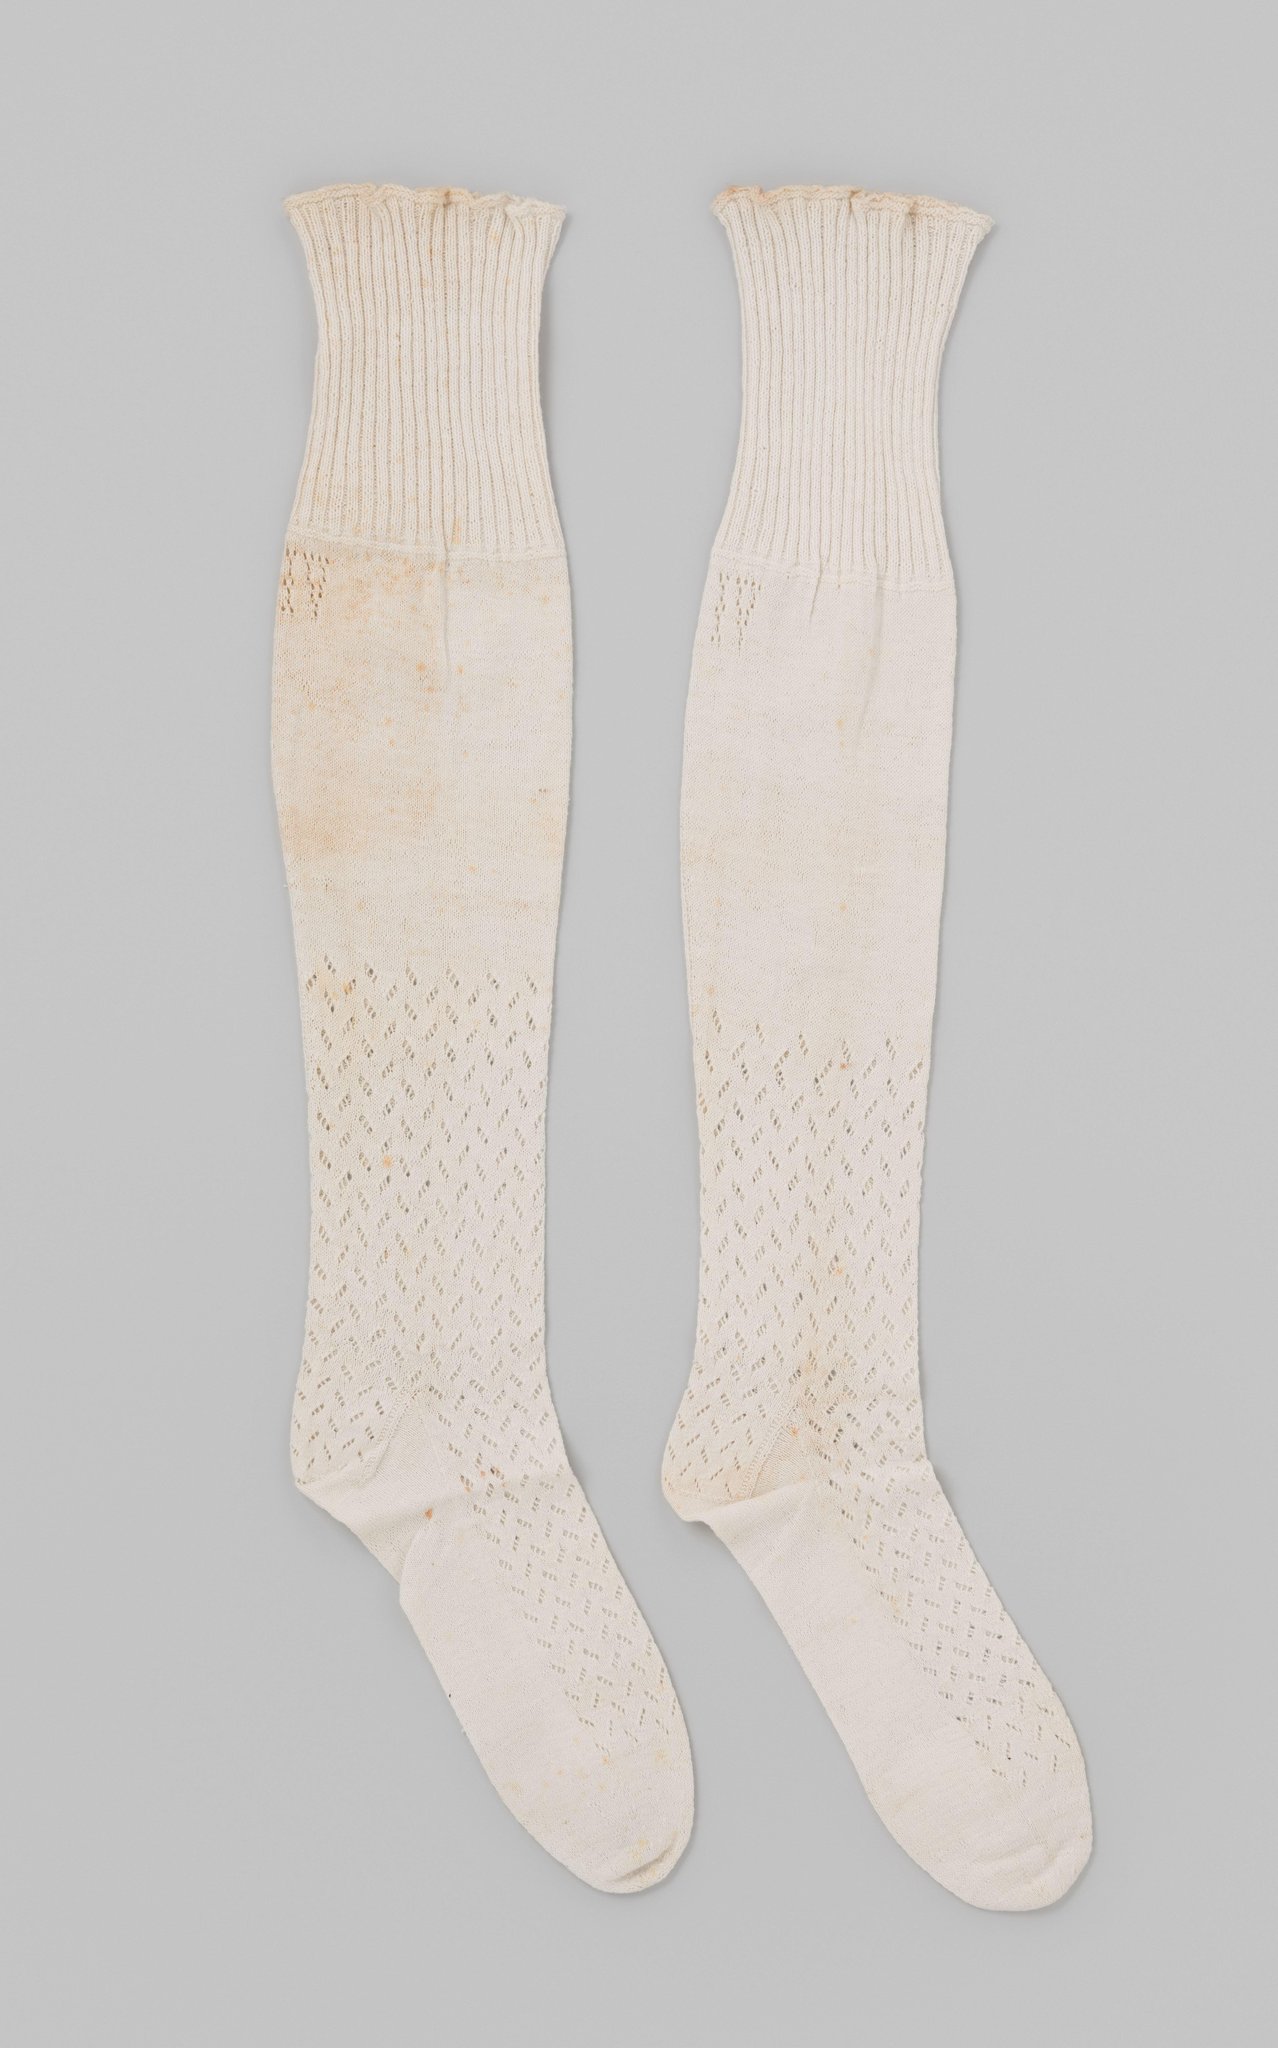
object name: childrenswear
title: Kous van ajour gebreid wit katoen, met een effen deel bij de kuit en bovenaan een brede boord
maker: Anonymous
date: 1900-1910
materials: cotton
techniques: embroidery, knitting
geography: surabaya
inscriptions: inscription: ‘'IV'’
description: Kous van ajour gebreid wit katoen in patroon van schuine strepen, met een effen deel bij de kuit en bovenaan een brede boord. In ajour gebreid 'IV' bovenaan aan de achterzijde.